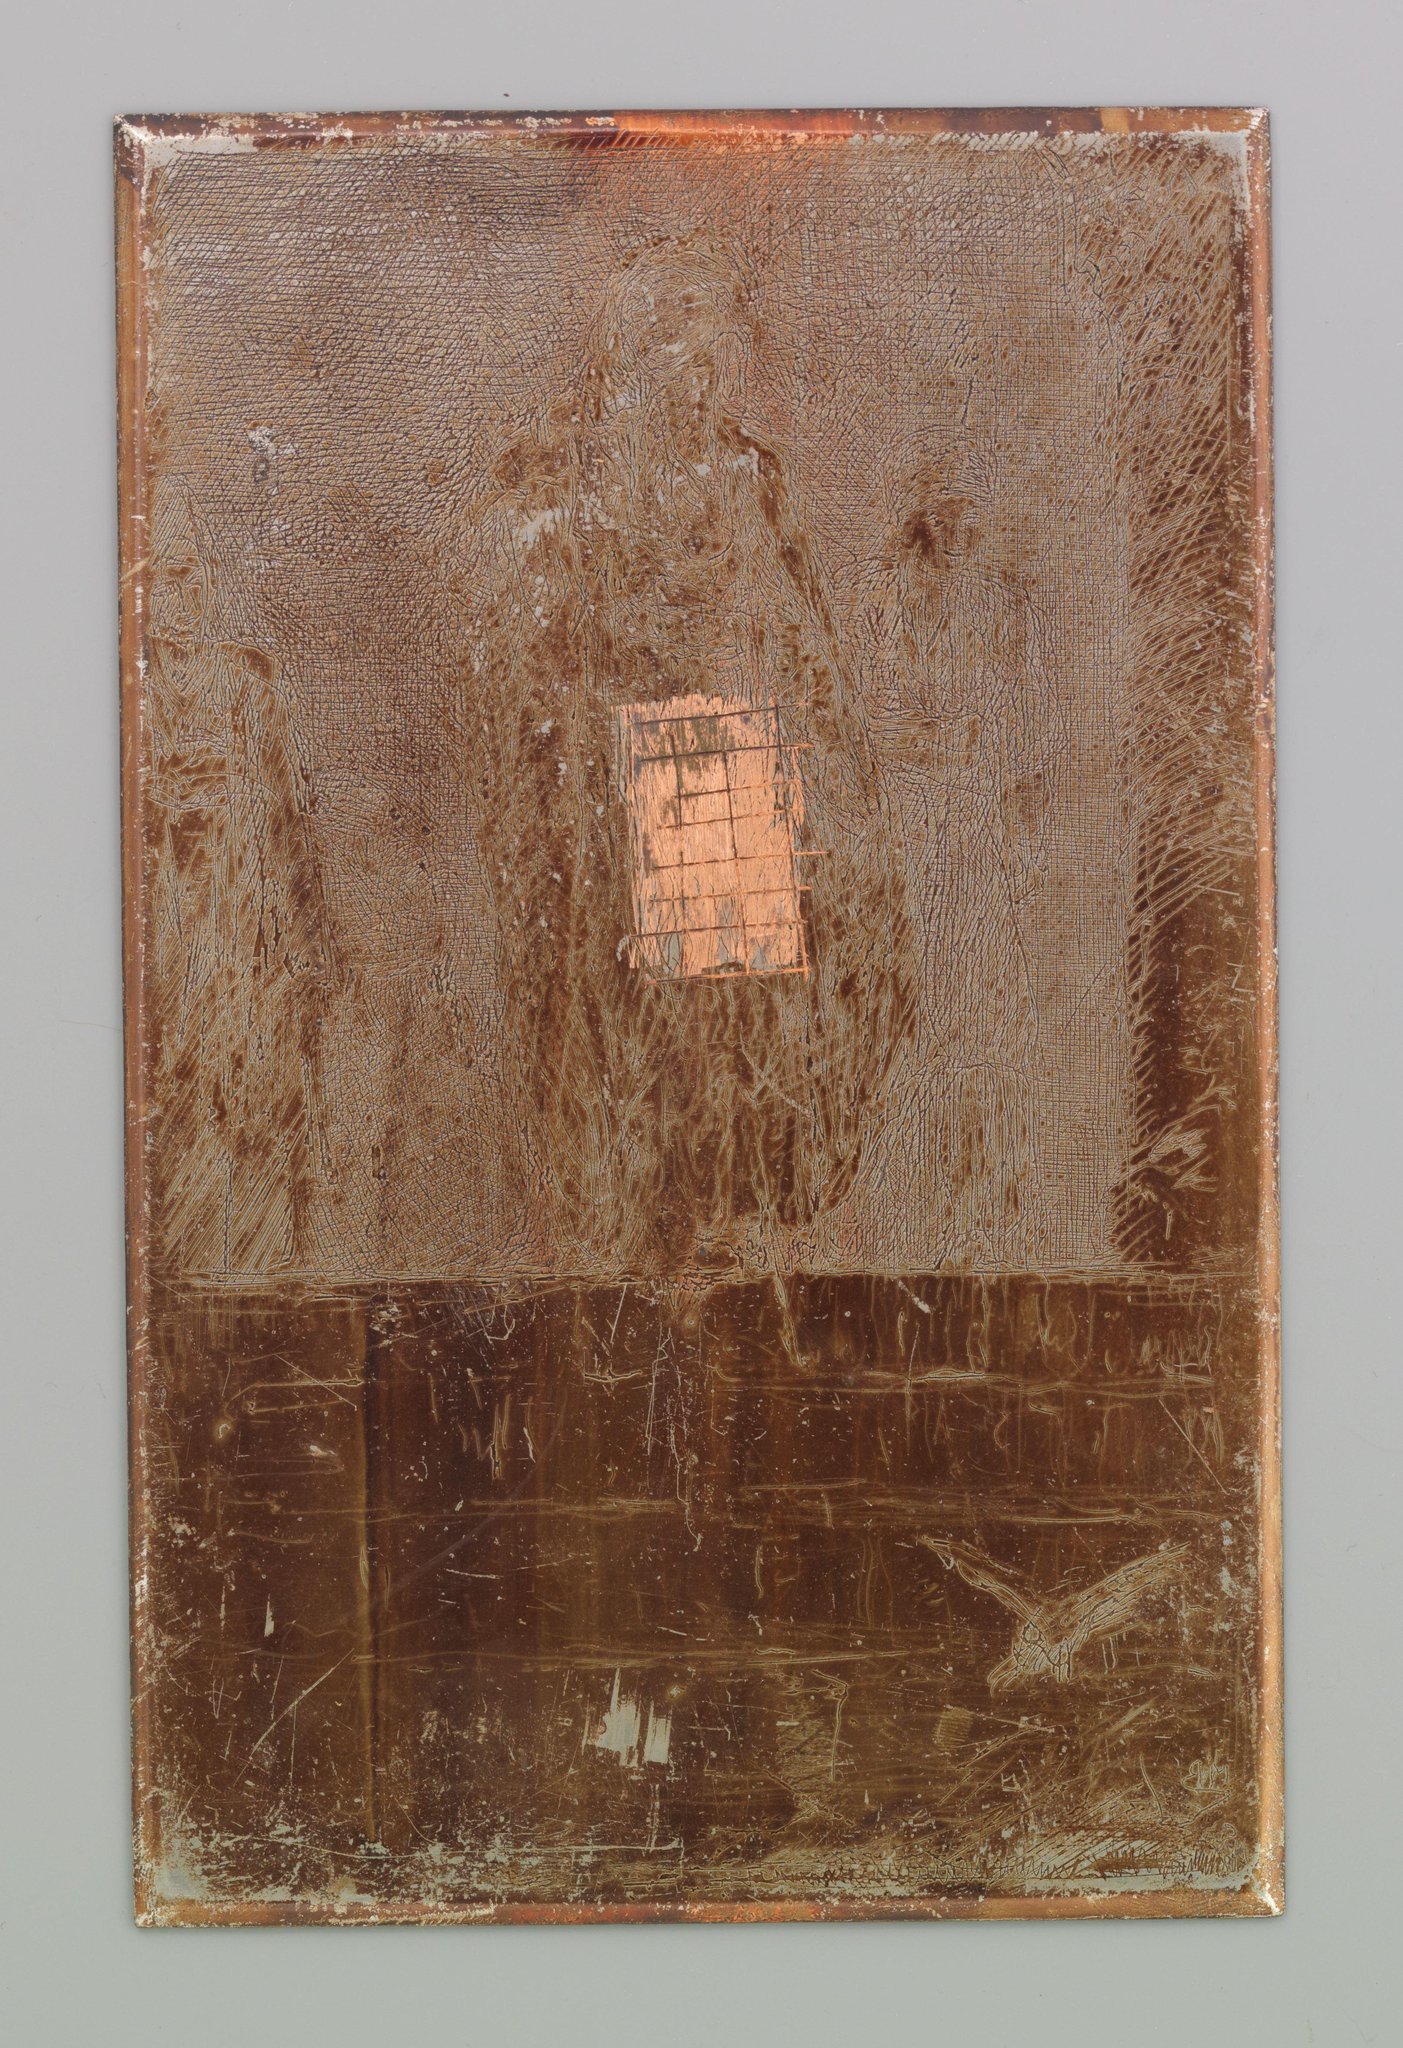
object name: copper plate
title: Op de trappen van de moskee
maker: marius bauer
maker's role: draughtsman, print maker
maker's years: 1867-1932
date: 1924-1932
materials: copper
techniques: etching